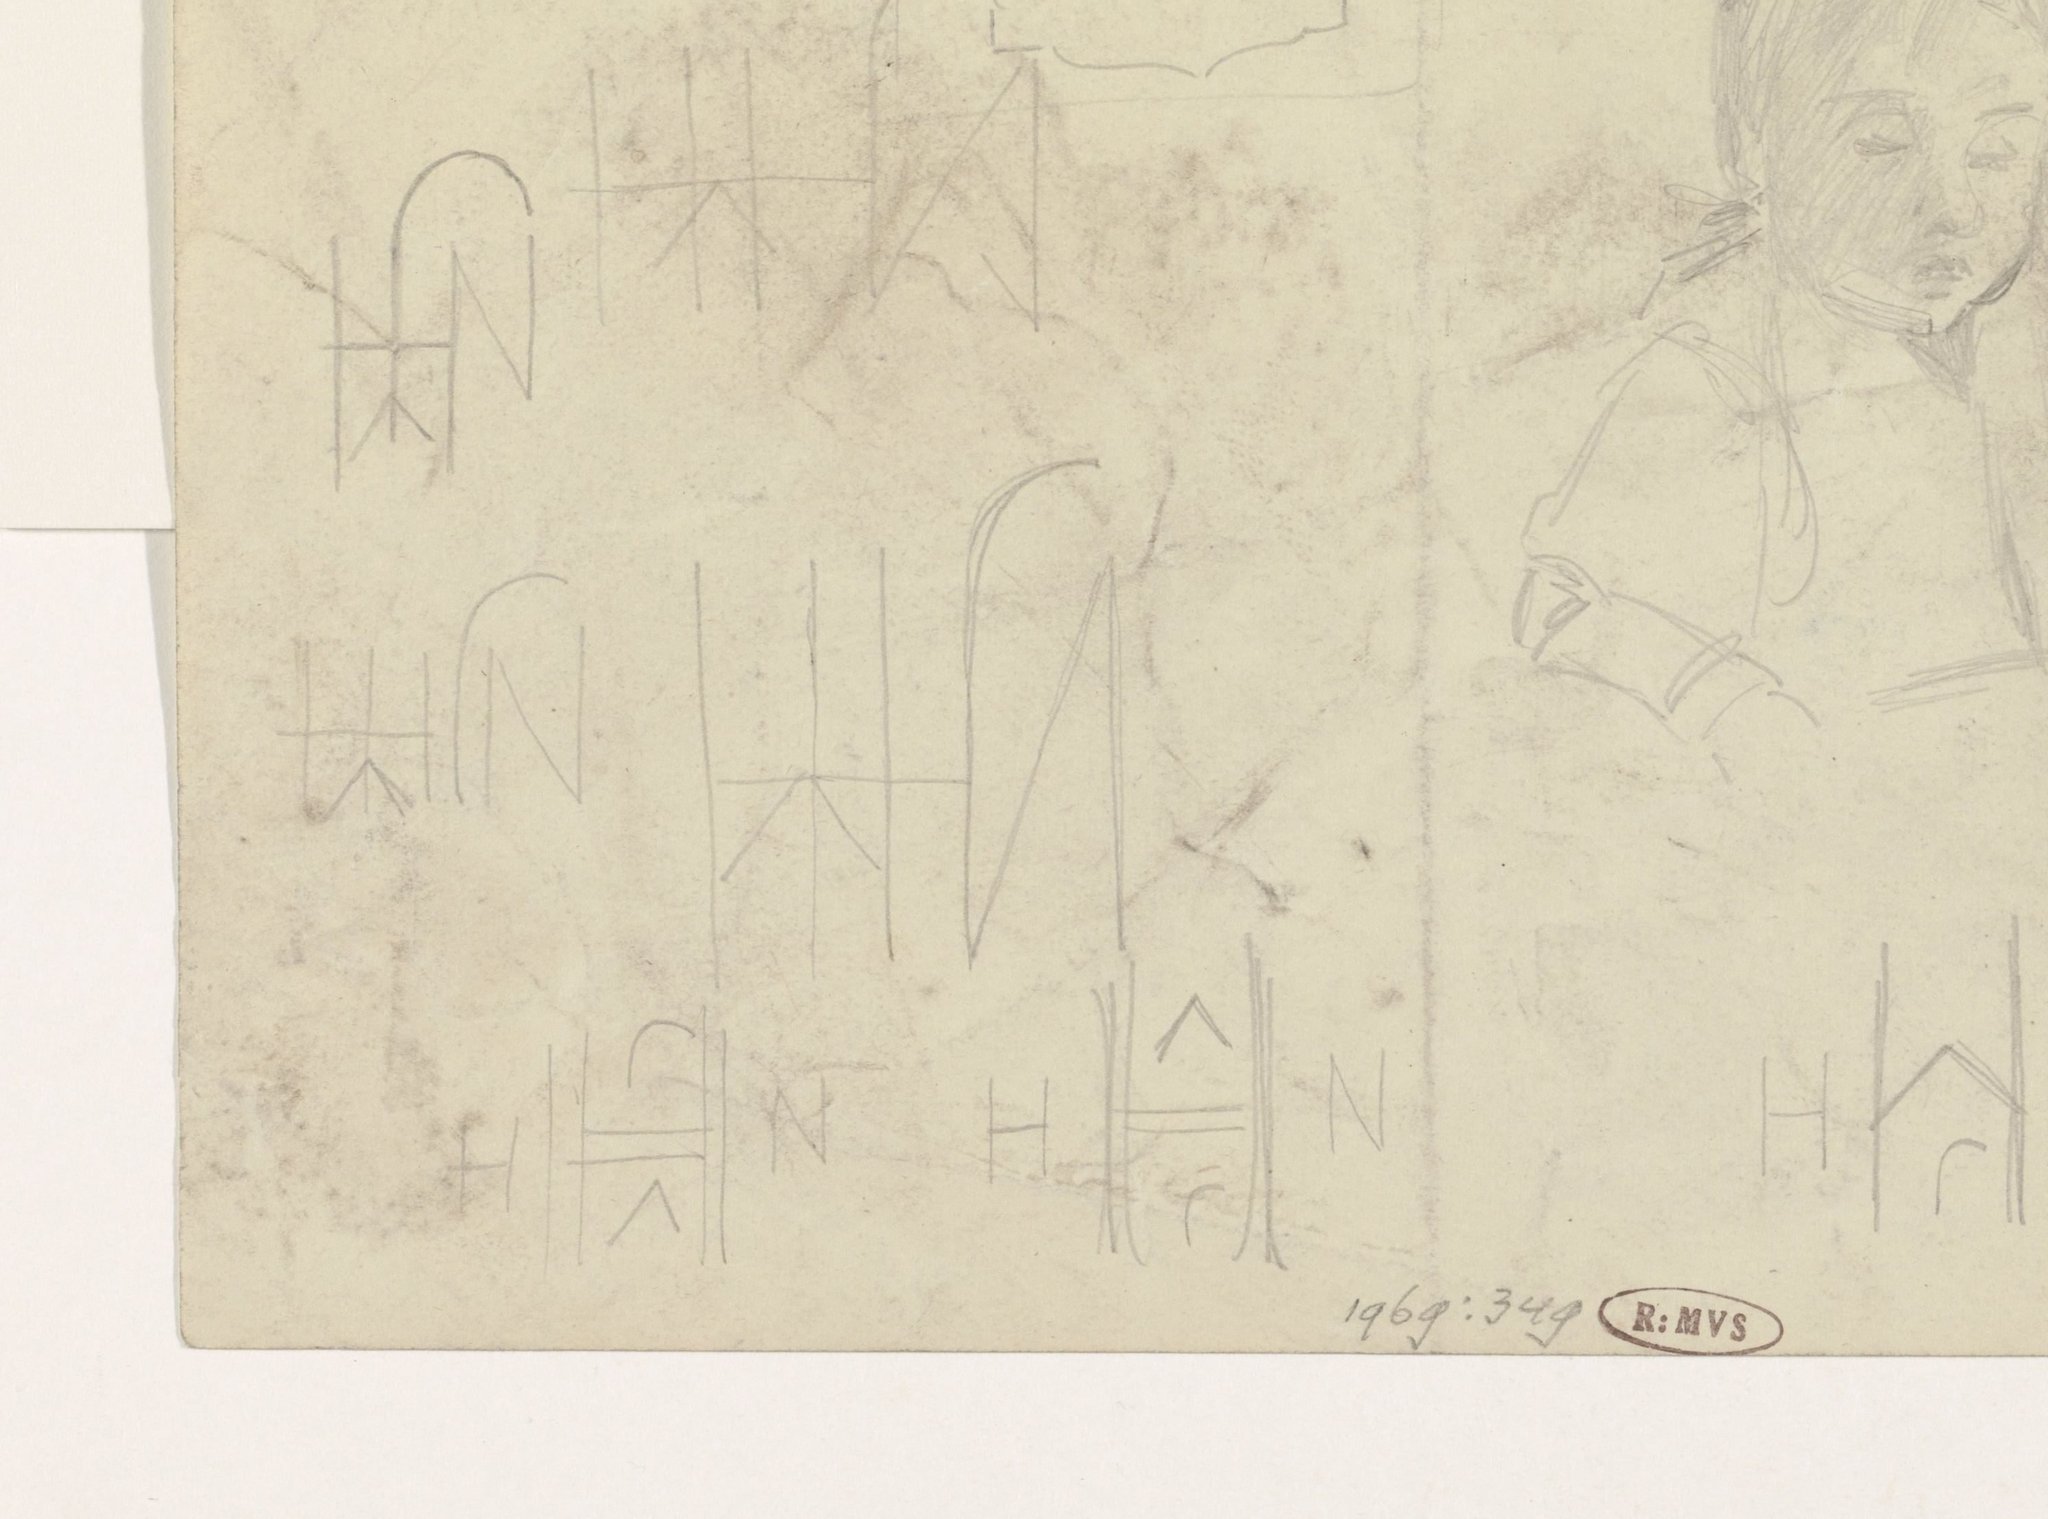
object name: drawing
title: Ontwerpen voor een monogram en kinderkopje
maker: carel adolph lion cachet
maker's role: draughtsman, print maker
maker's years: 1864-1945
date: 1874-1945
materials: paper, pencil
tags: letter combinations such as letterword, anagram, letter square, monogram, etc.